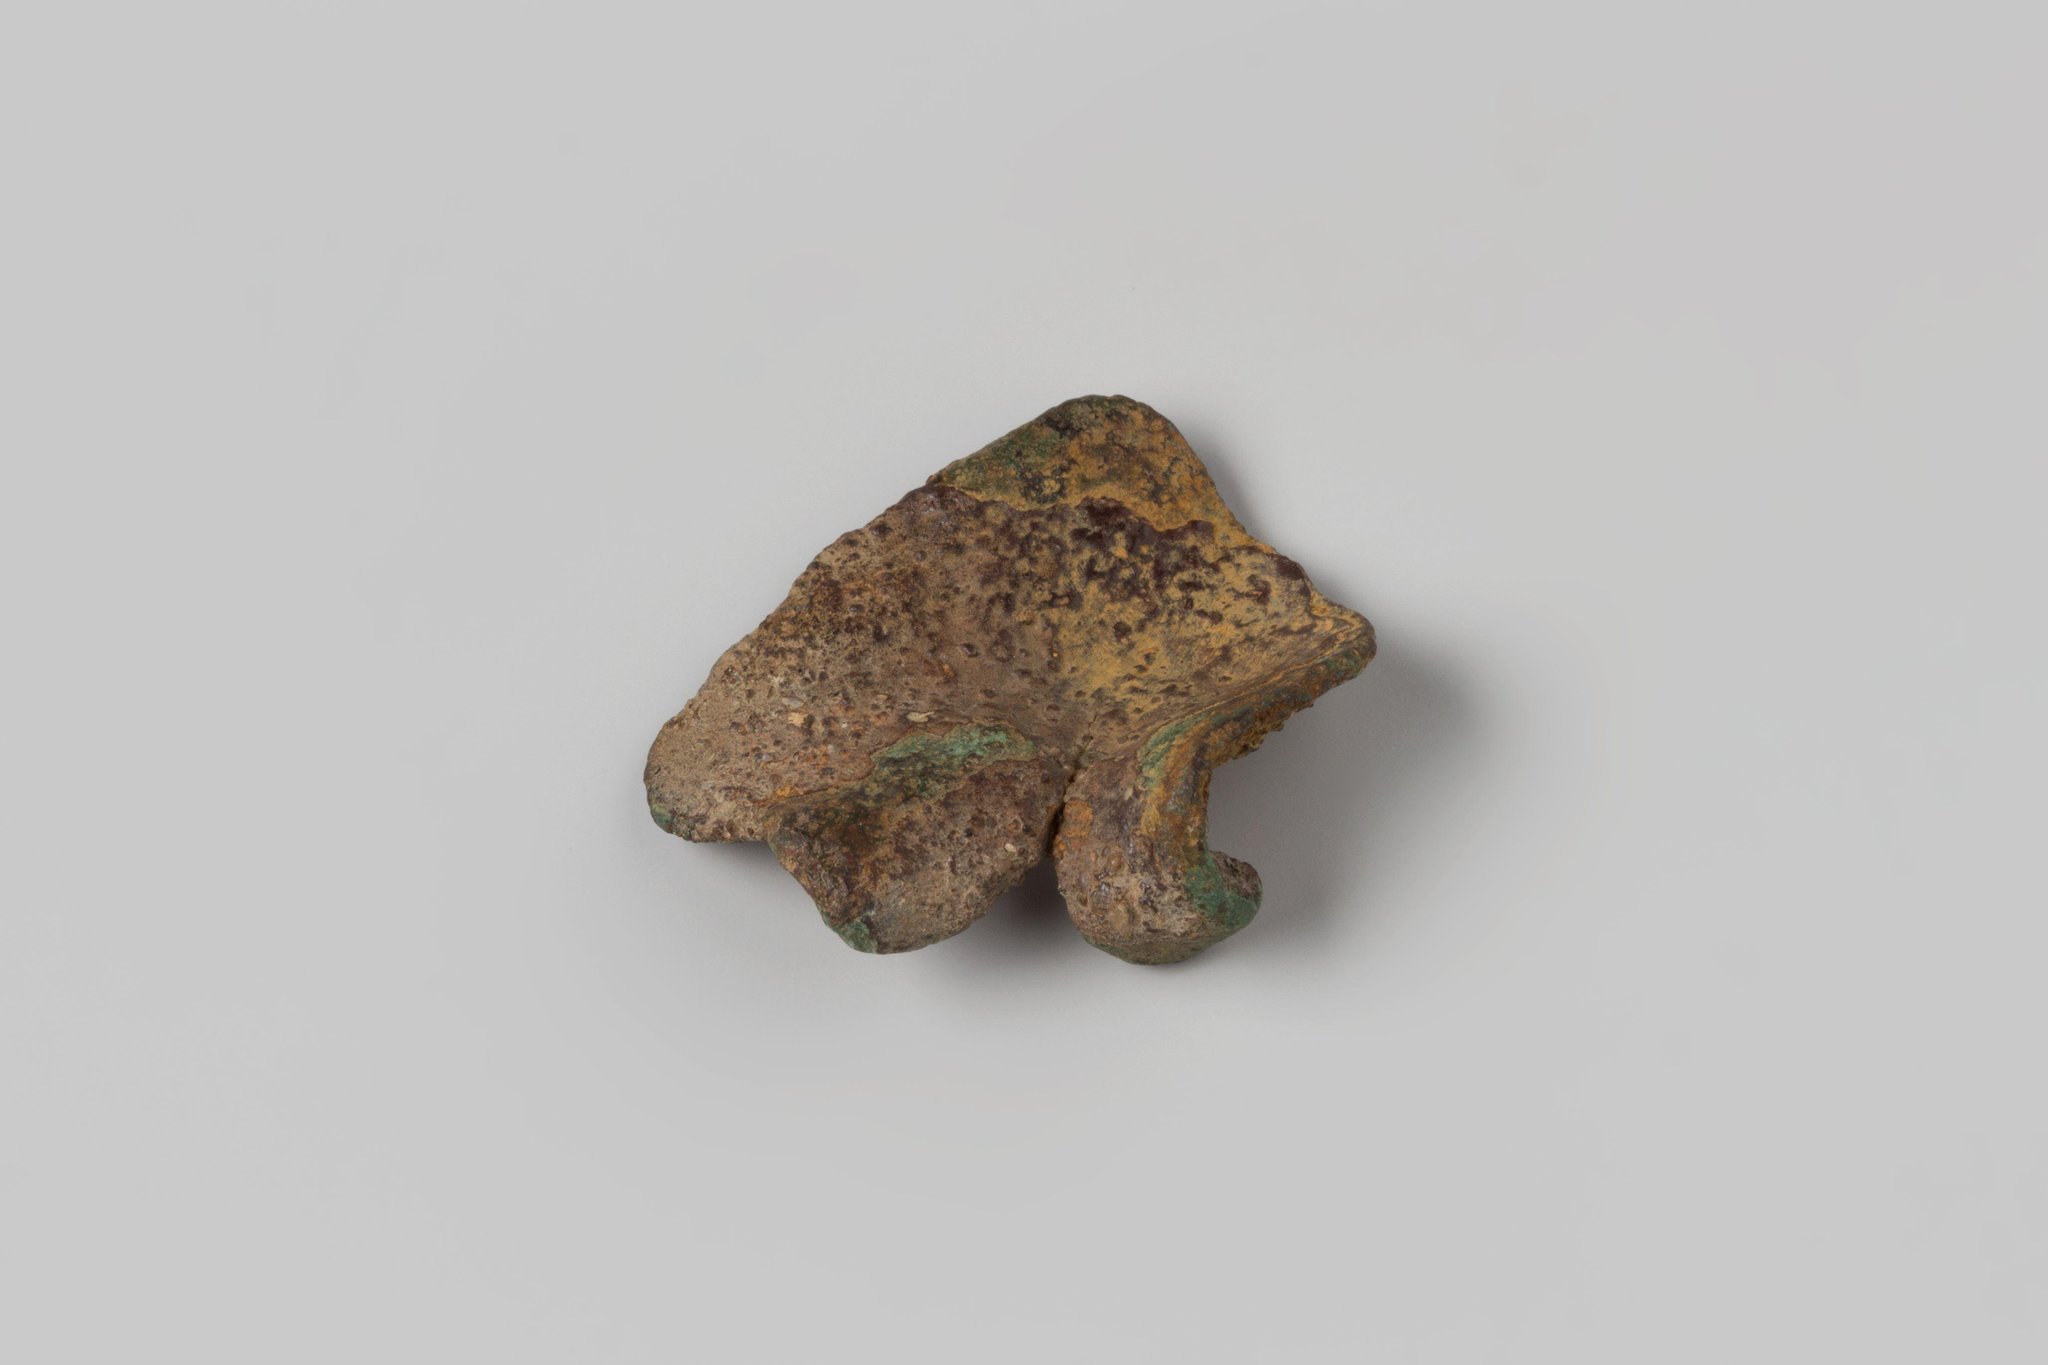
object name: scheepswrakvondst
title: Fragment van koper uit het wrak van de Oost-Indiëvaarder Hollandia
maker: Anonymous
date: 1700-1743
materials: copper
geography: netherlands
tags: verenigde oostindische compagnie, hollandia (schip), annet